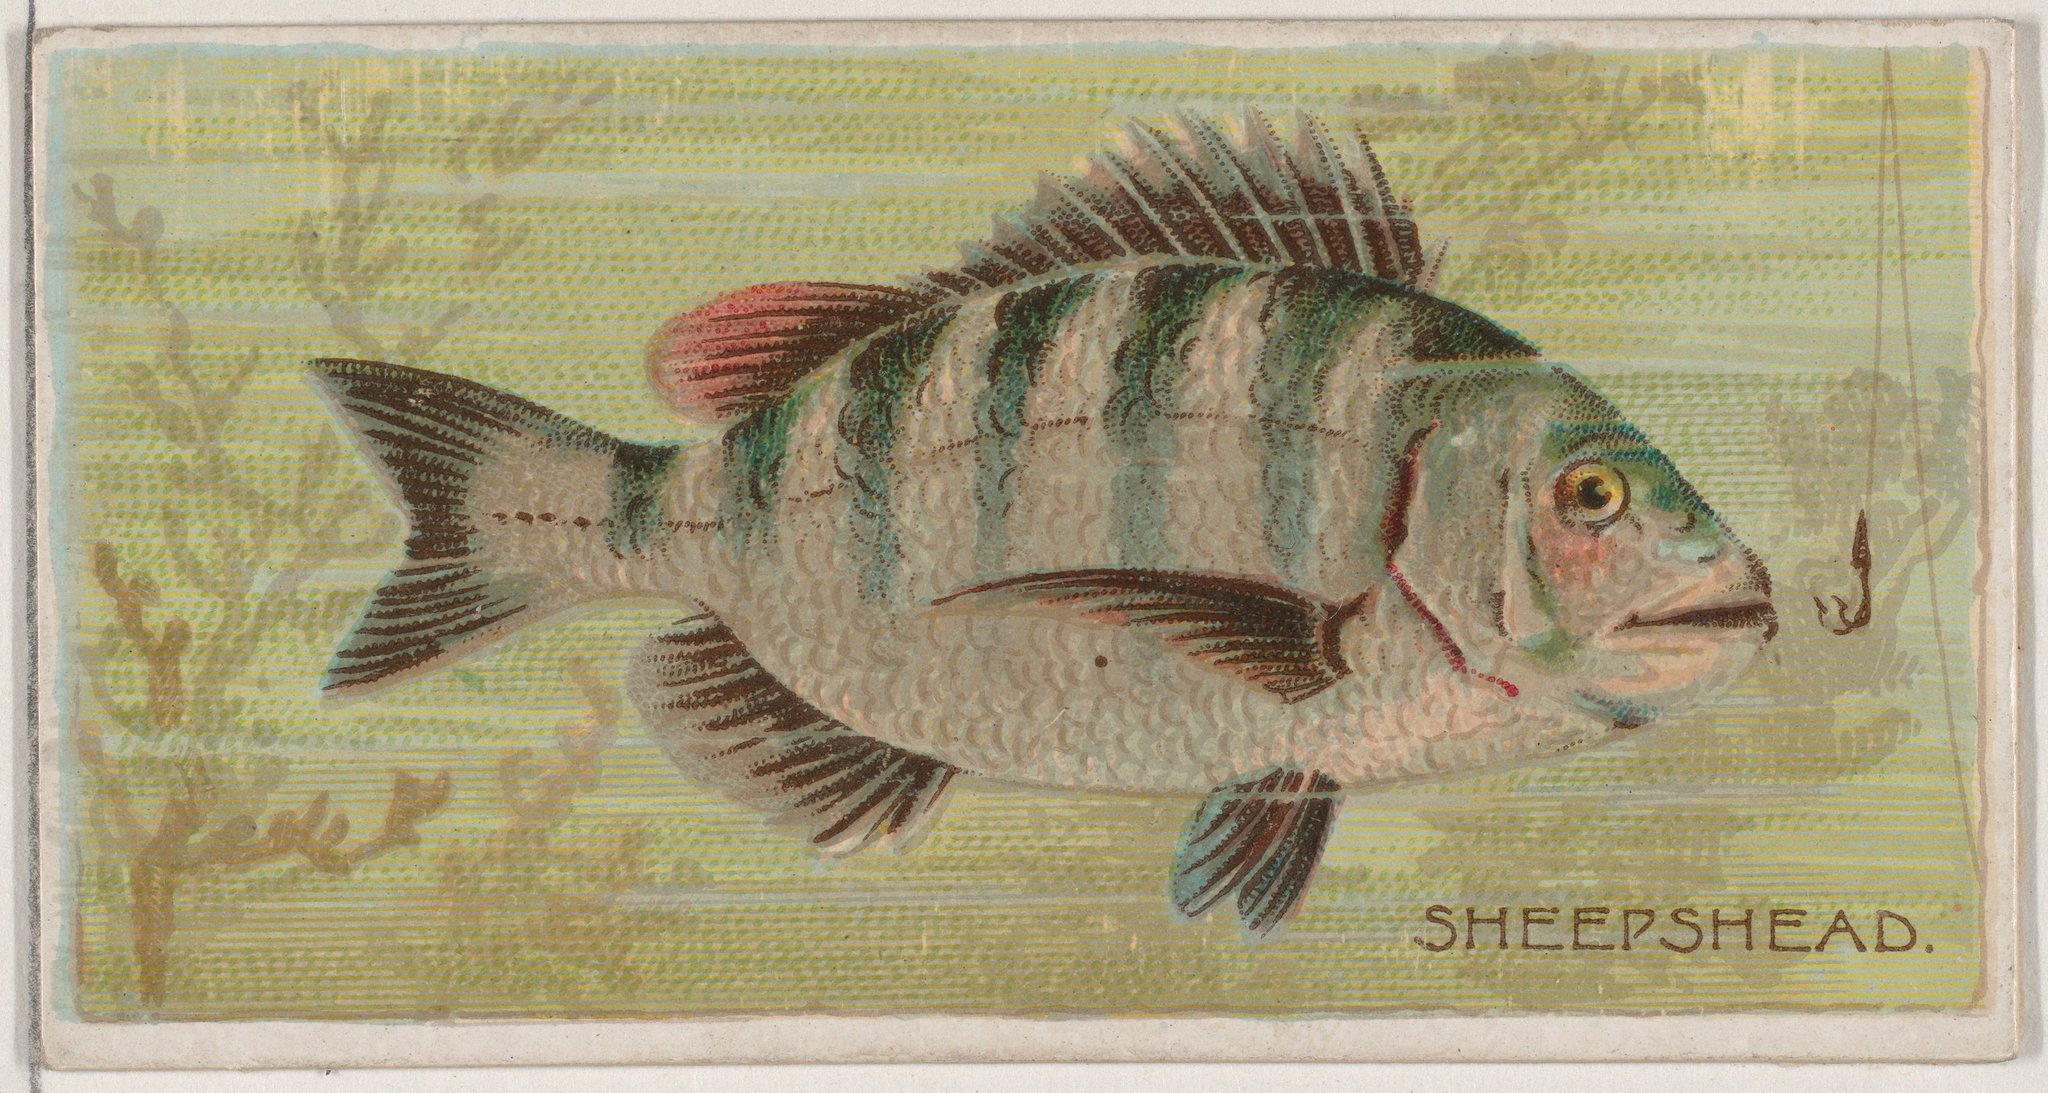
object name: print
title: Sheepshead, from the series Fishers and Fish (N74) for Duke brand cigarettes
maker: knapp & company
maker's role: lithographer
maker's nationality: american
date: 1888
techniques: color lithograph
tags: fish